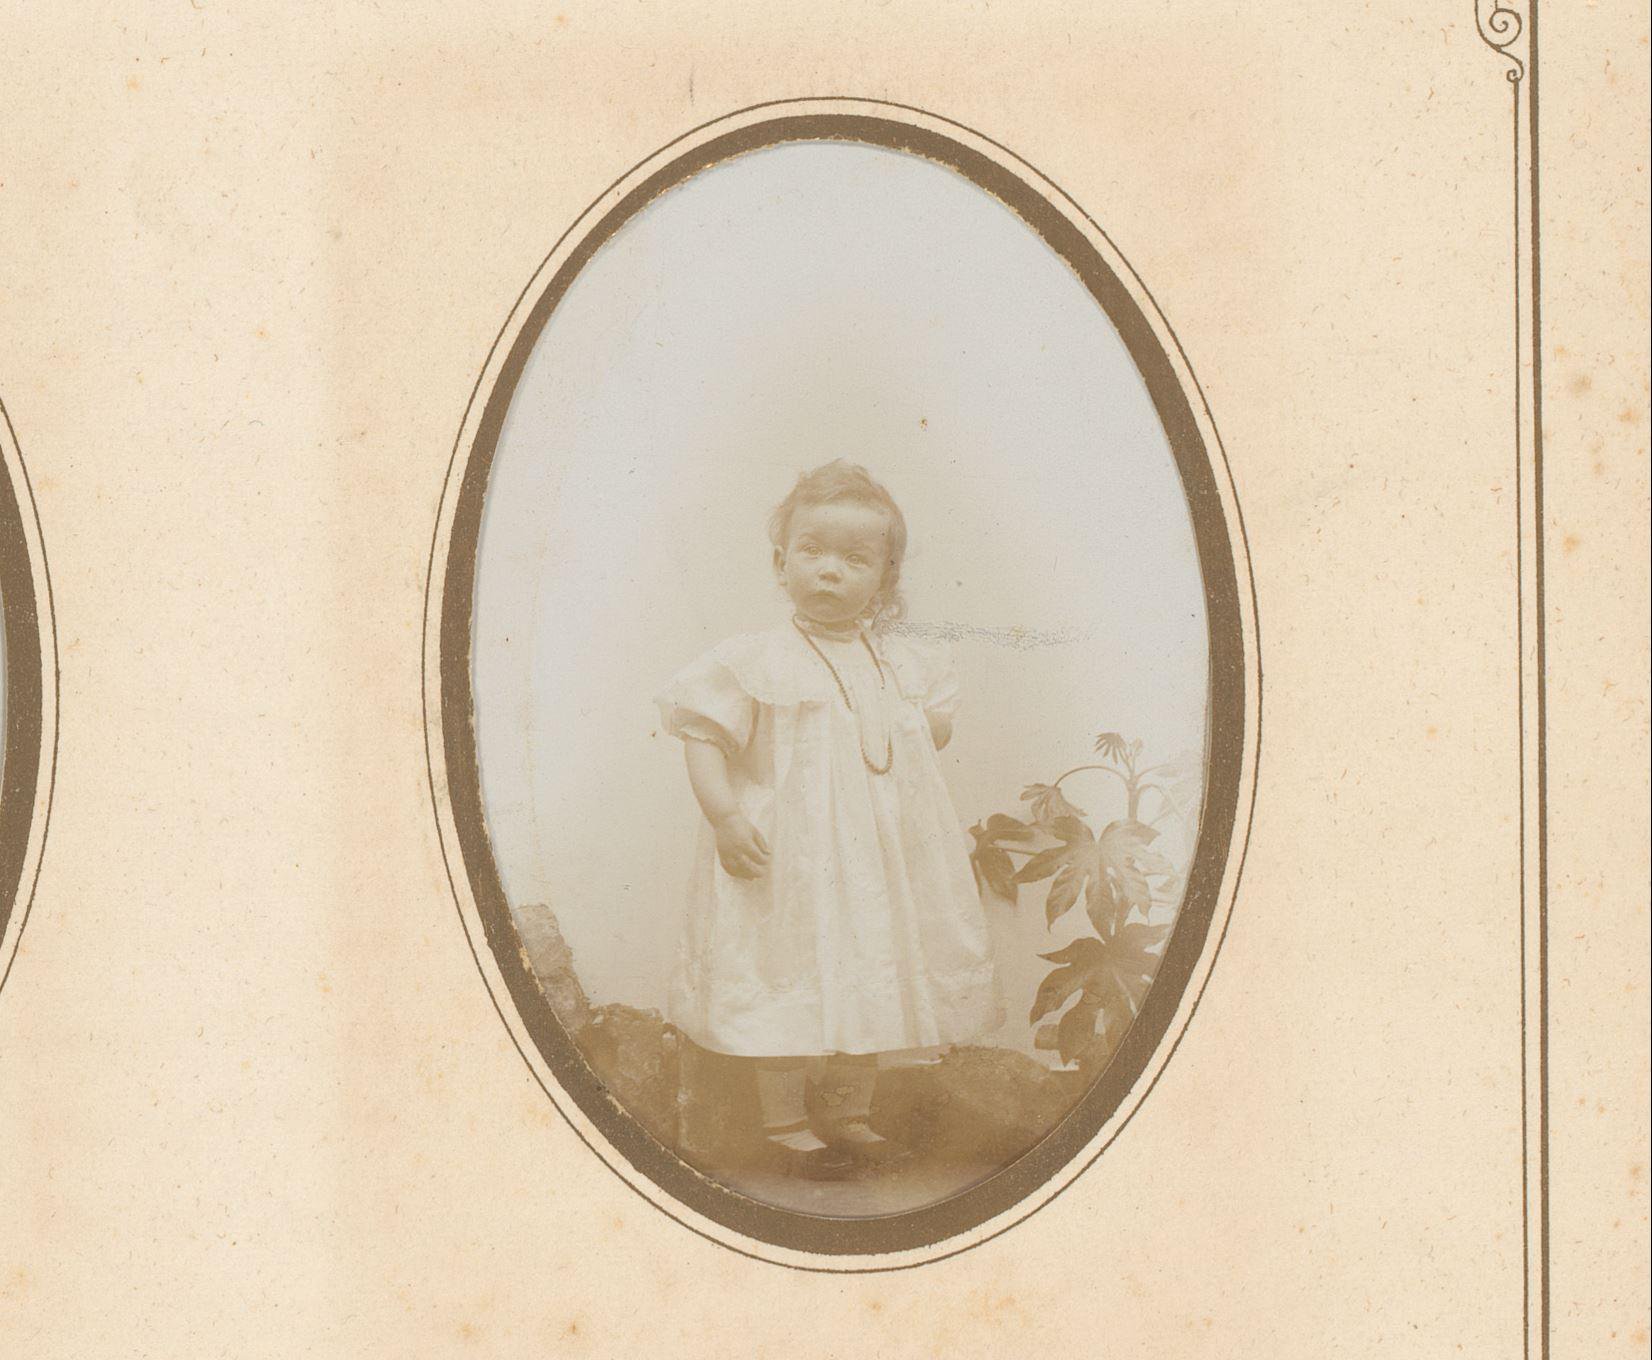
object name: photograph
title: Portret van een peuter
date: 1901-1905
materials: cardboard, photographic support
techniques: collodion silver print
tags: toddler, historical persons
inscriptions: inscription: ‘Theunisse & Labots/ voorheen Ed. Radermacher/ Rotterdam/ Kruiskade 20/ hoek kerklaan’, annotation: ‘Mon Antoinette à/ l'age de 1 an et 8 moins/ Mai 1901’